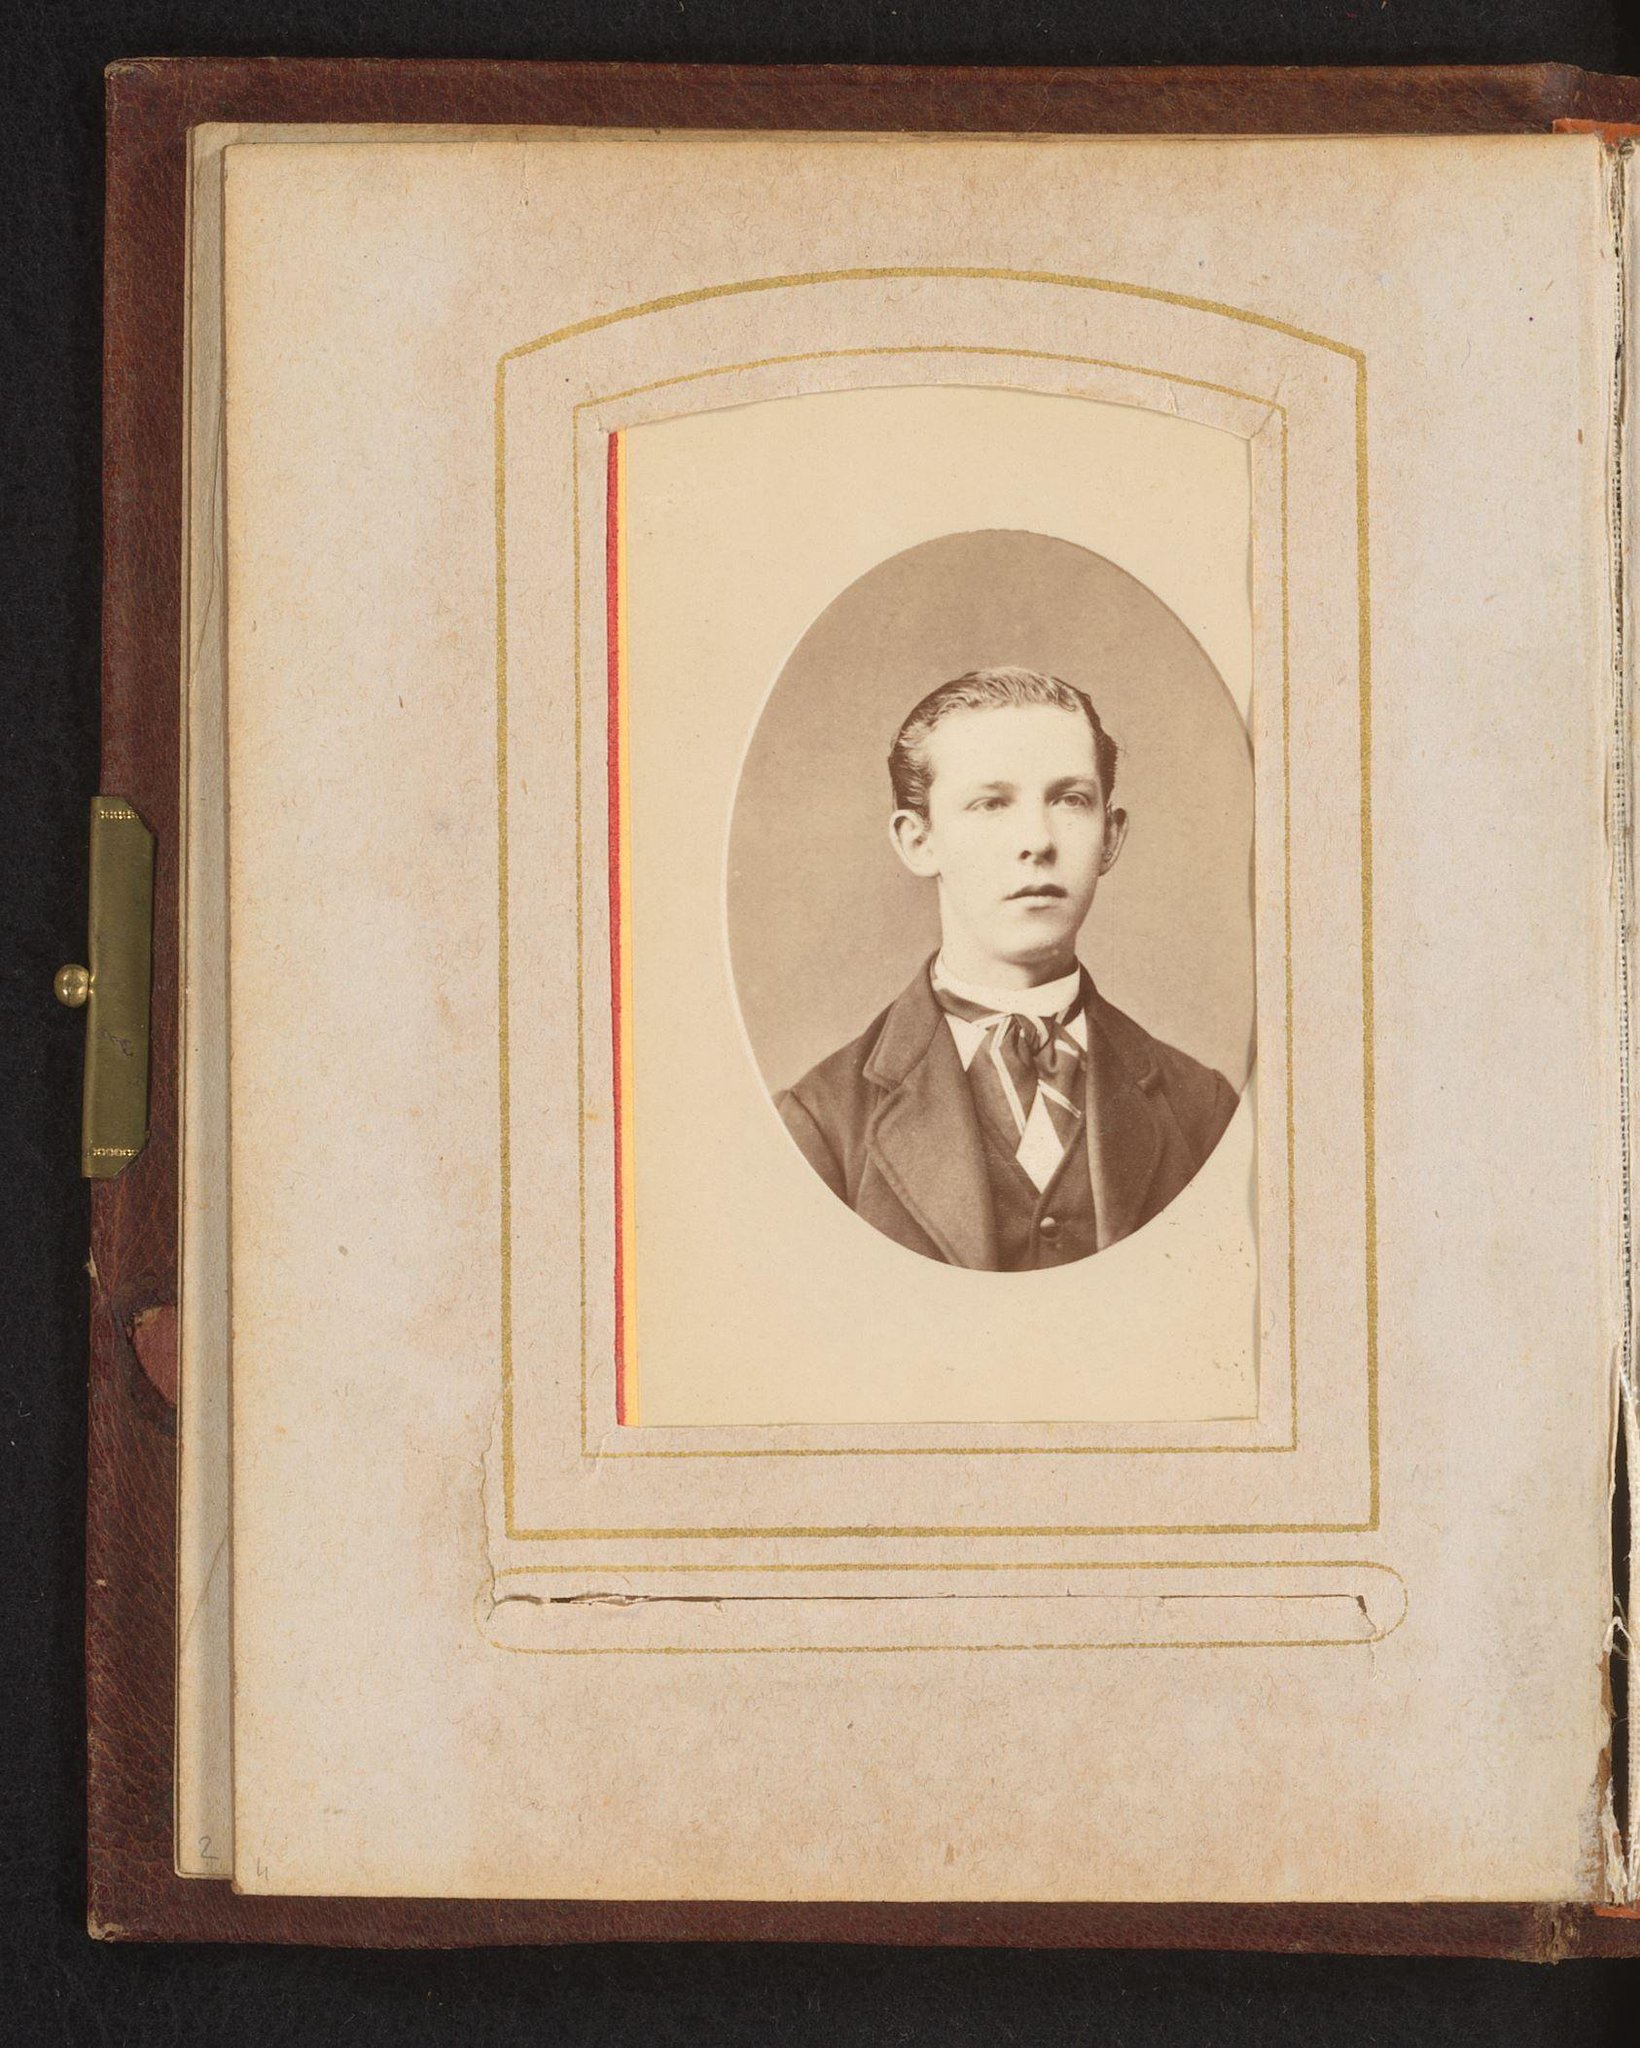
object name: photograph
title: Portret van een jongeman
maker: johannes franciscus lomans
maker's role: fotograaf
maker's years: 1837-1879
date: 1867-1872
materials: cardboard, photographic support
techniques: albumen print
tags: historical persons, youth, adolescent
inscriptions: inscription: ‘J.F. Lomans/ Firma/ Sellbach & Lomans/ Leeuwarden/ Grachtswal/ (...)’